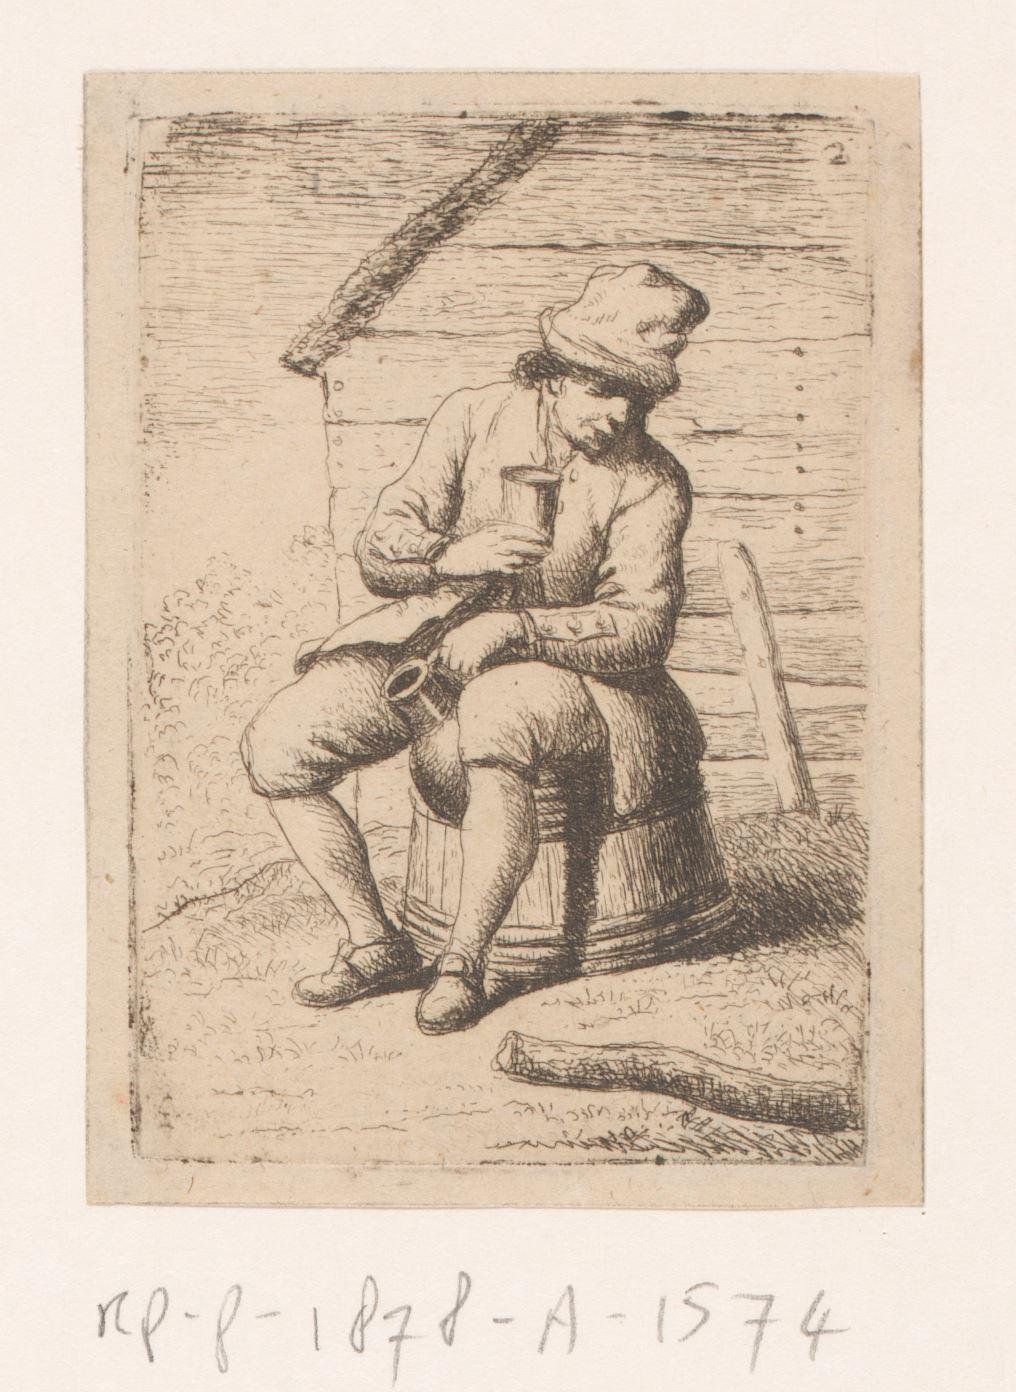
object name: print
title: Drinkende boer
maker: hendrik willem schweickhardt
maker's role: draughtsman, painter, print maker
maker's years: 1746-1797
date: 1756-1797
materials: paper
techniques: etching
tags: farmers, drinking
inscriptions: collector's mark: Lugt 2228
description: Behoort tot een serie van acht prenten met boeren.